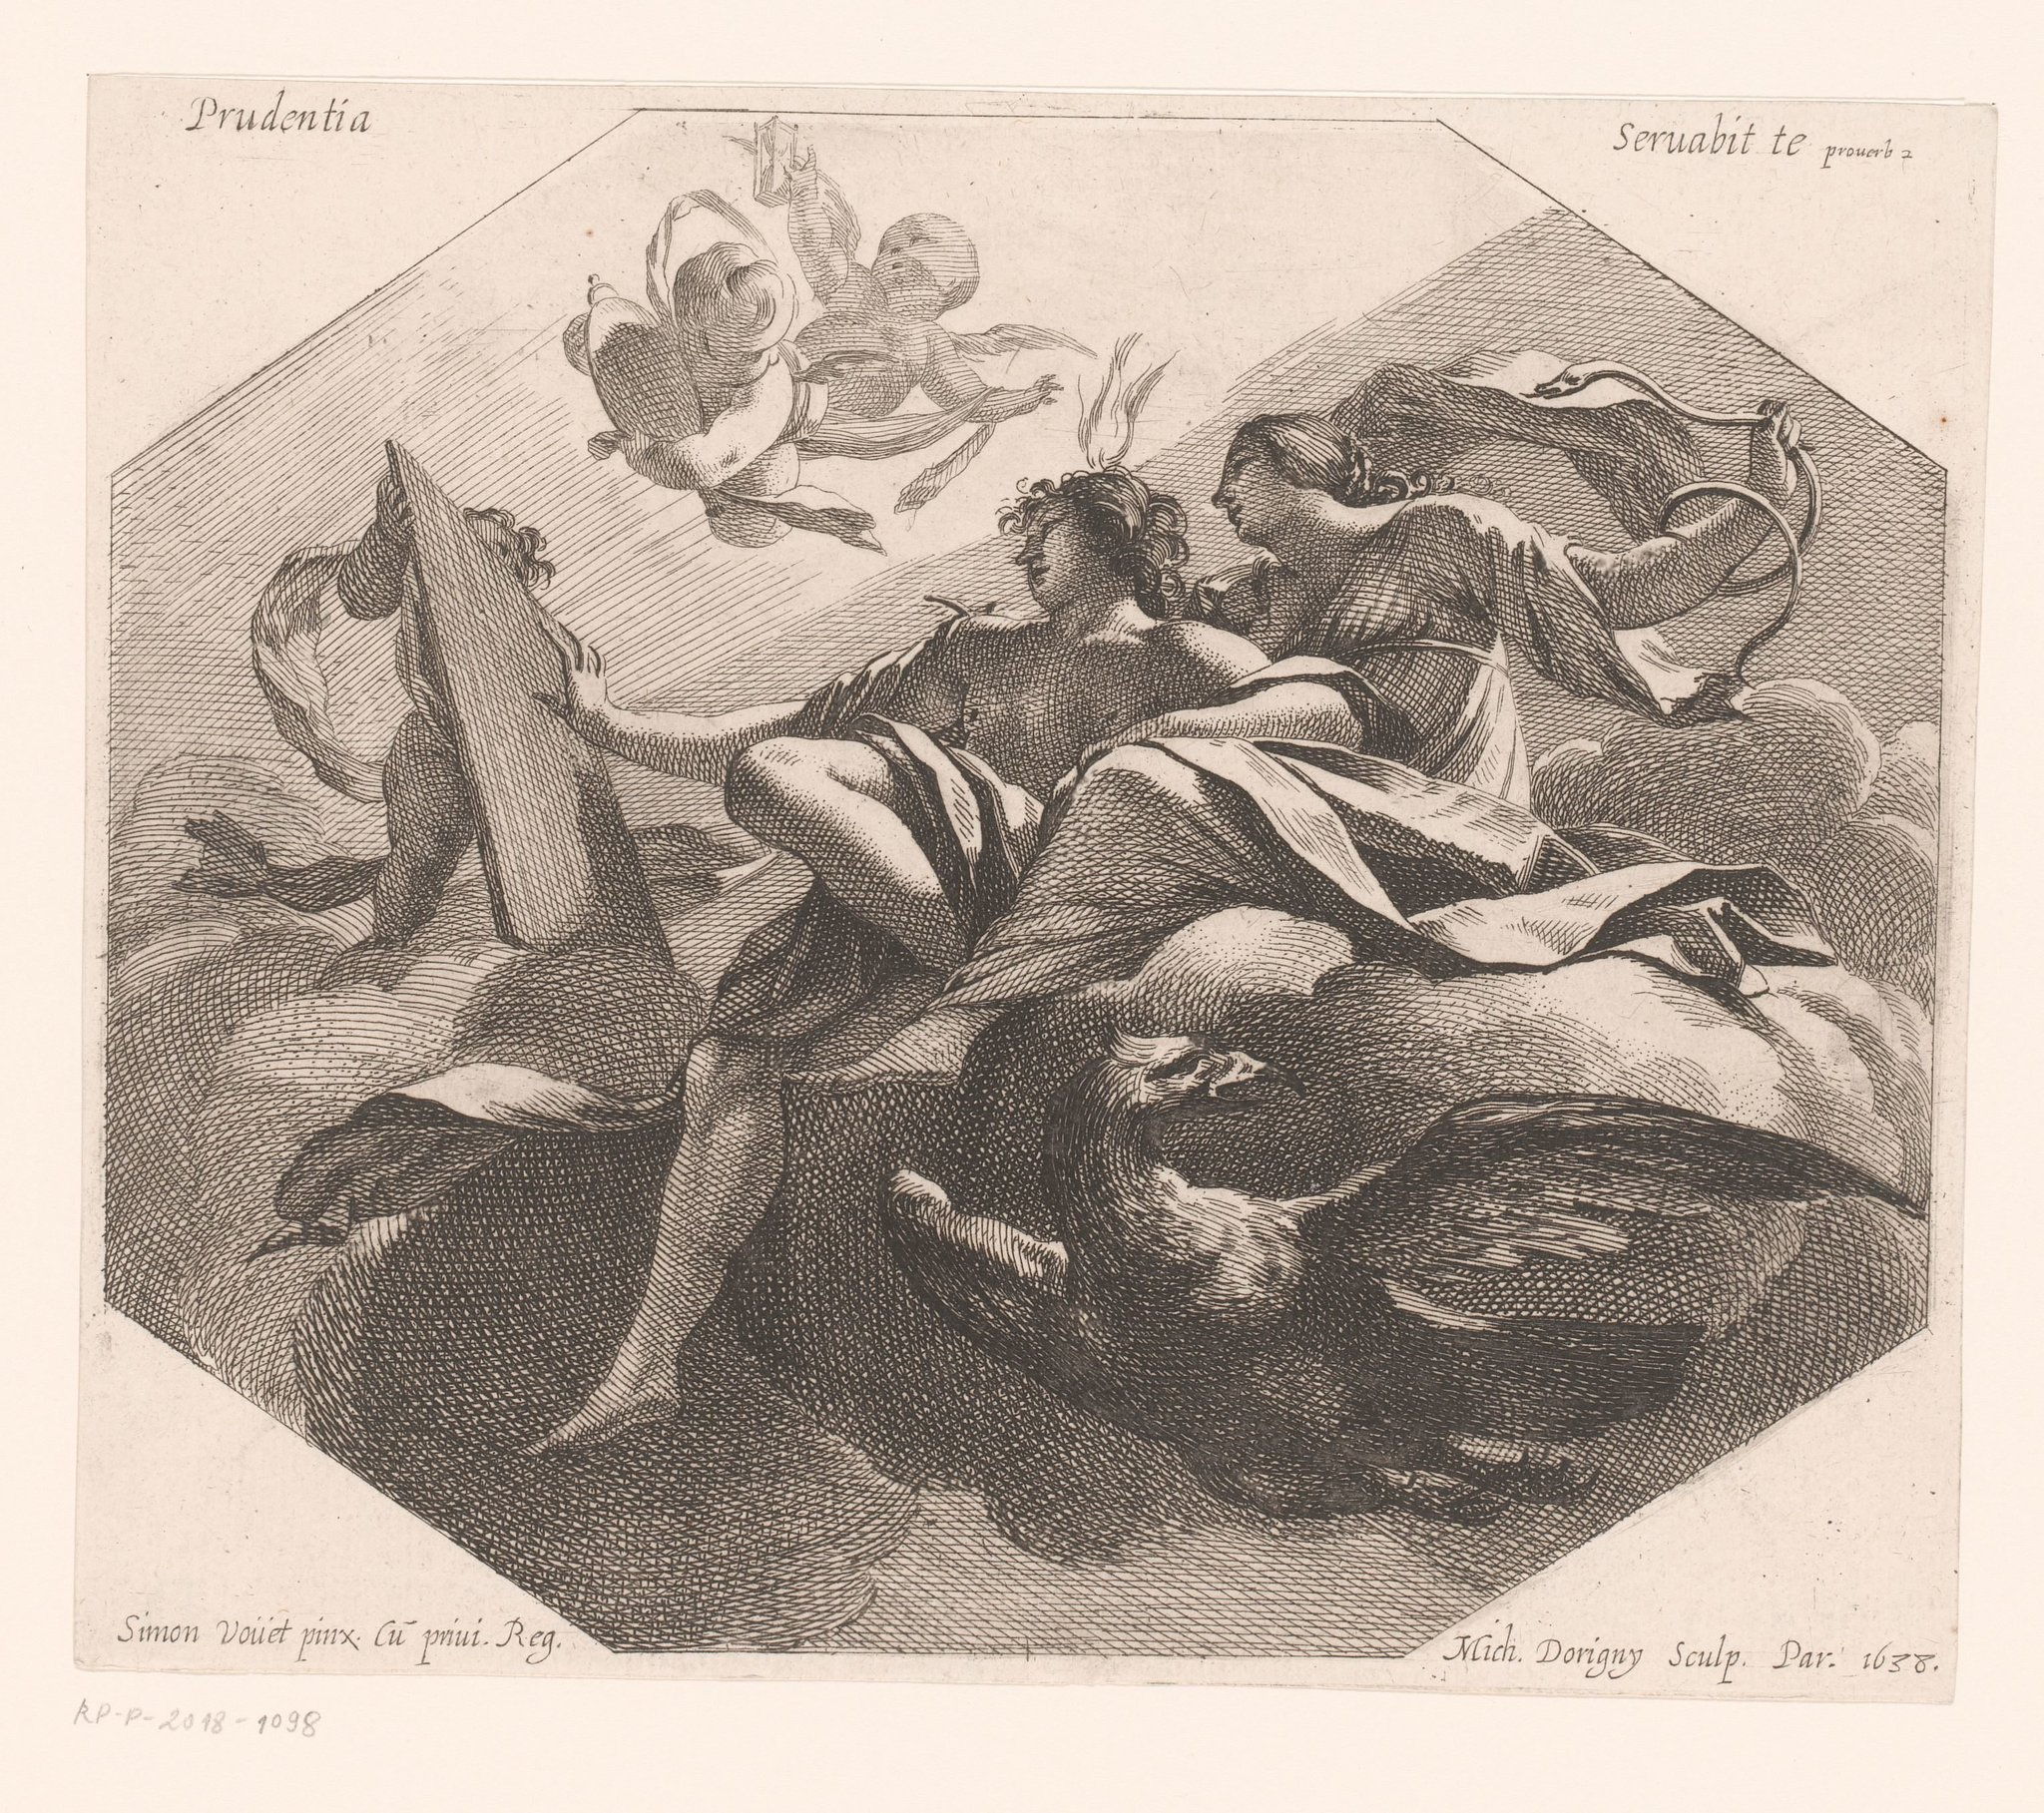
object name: print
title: Kardinale deugden op een wolk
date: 1638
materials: paper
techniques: engraving, etching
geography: paris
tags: prudence, 'prudentia'; 'prudenza' (ripa) ~ one of the four cardinal virtues, (story of) jupiter (zeus), assemblies of the gods in the air, possibly on the clouds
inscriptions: collector's mark: Lugt 2228